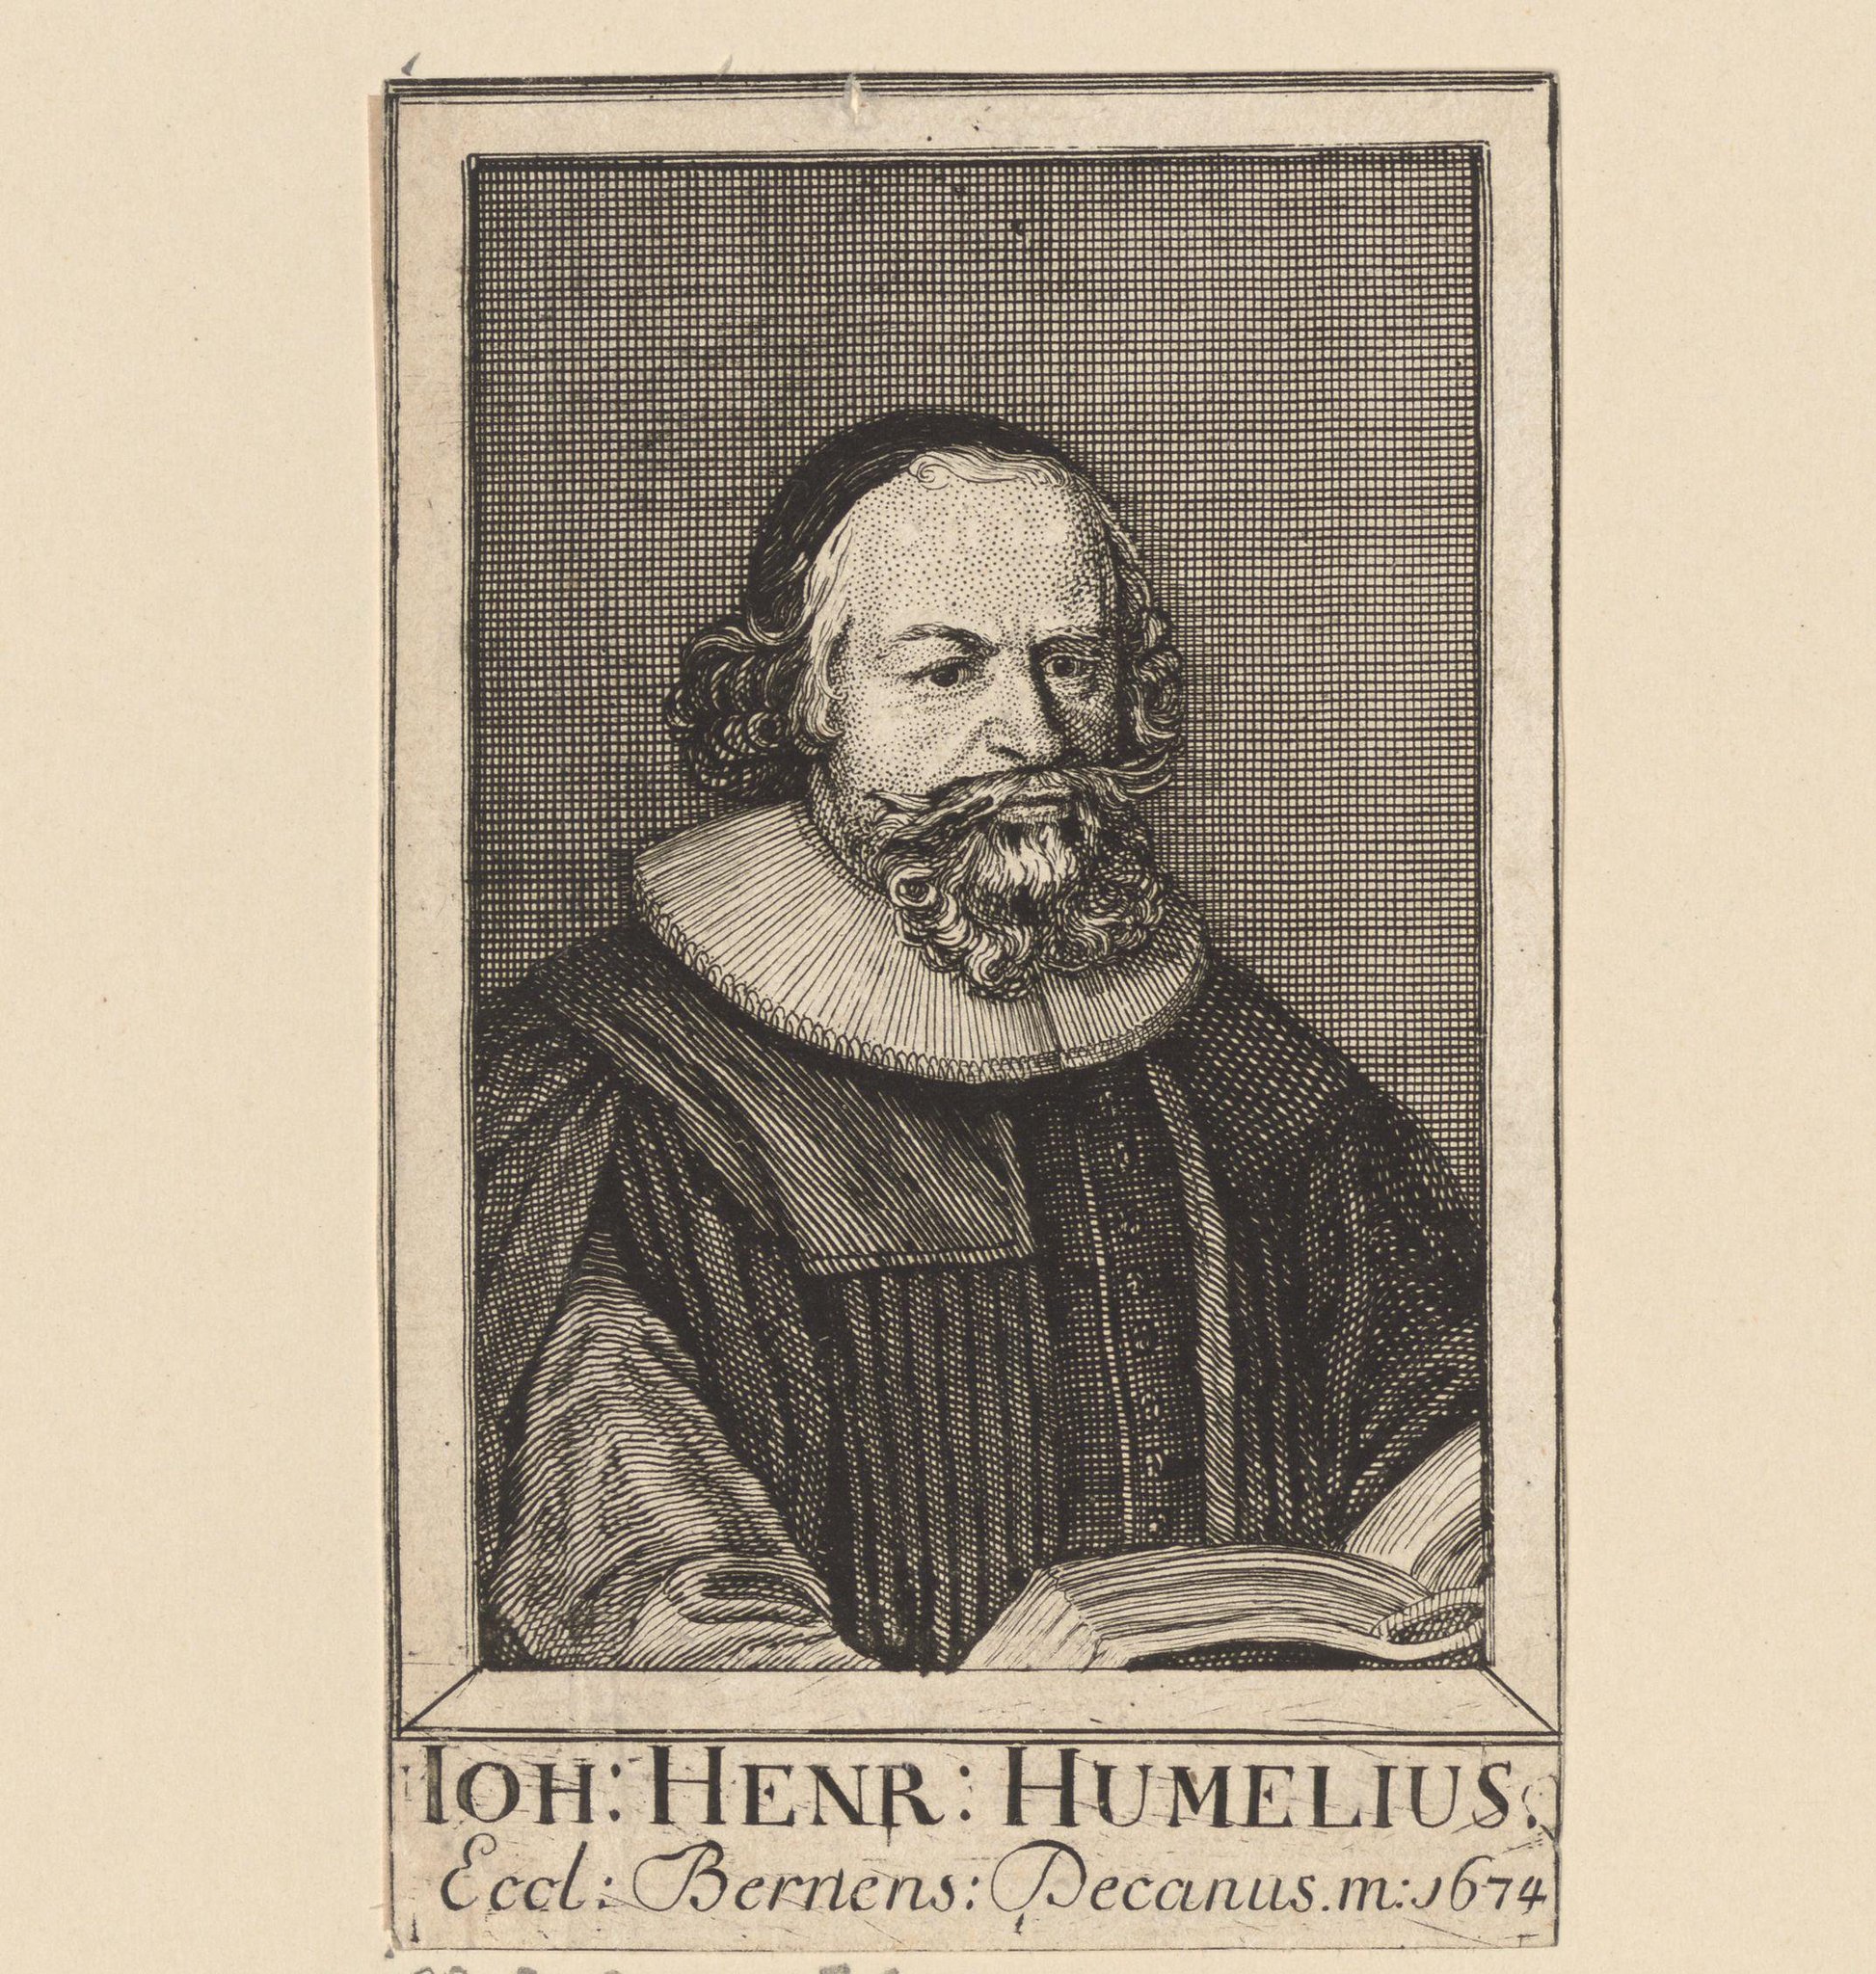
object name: print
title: Portret van Johann Heinrich Hummel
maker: Anonymous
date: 1674-1699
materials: paper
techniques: engraving, etching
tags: theologian, historical persons